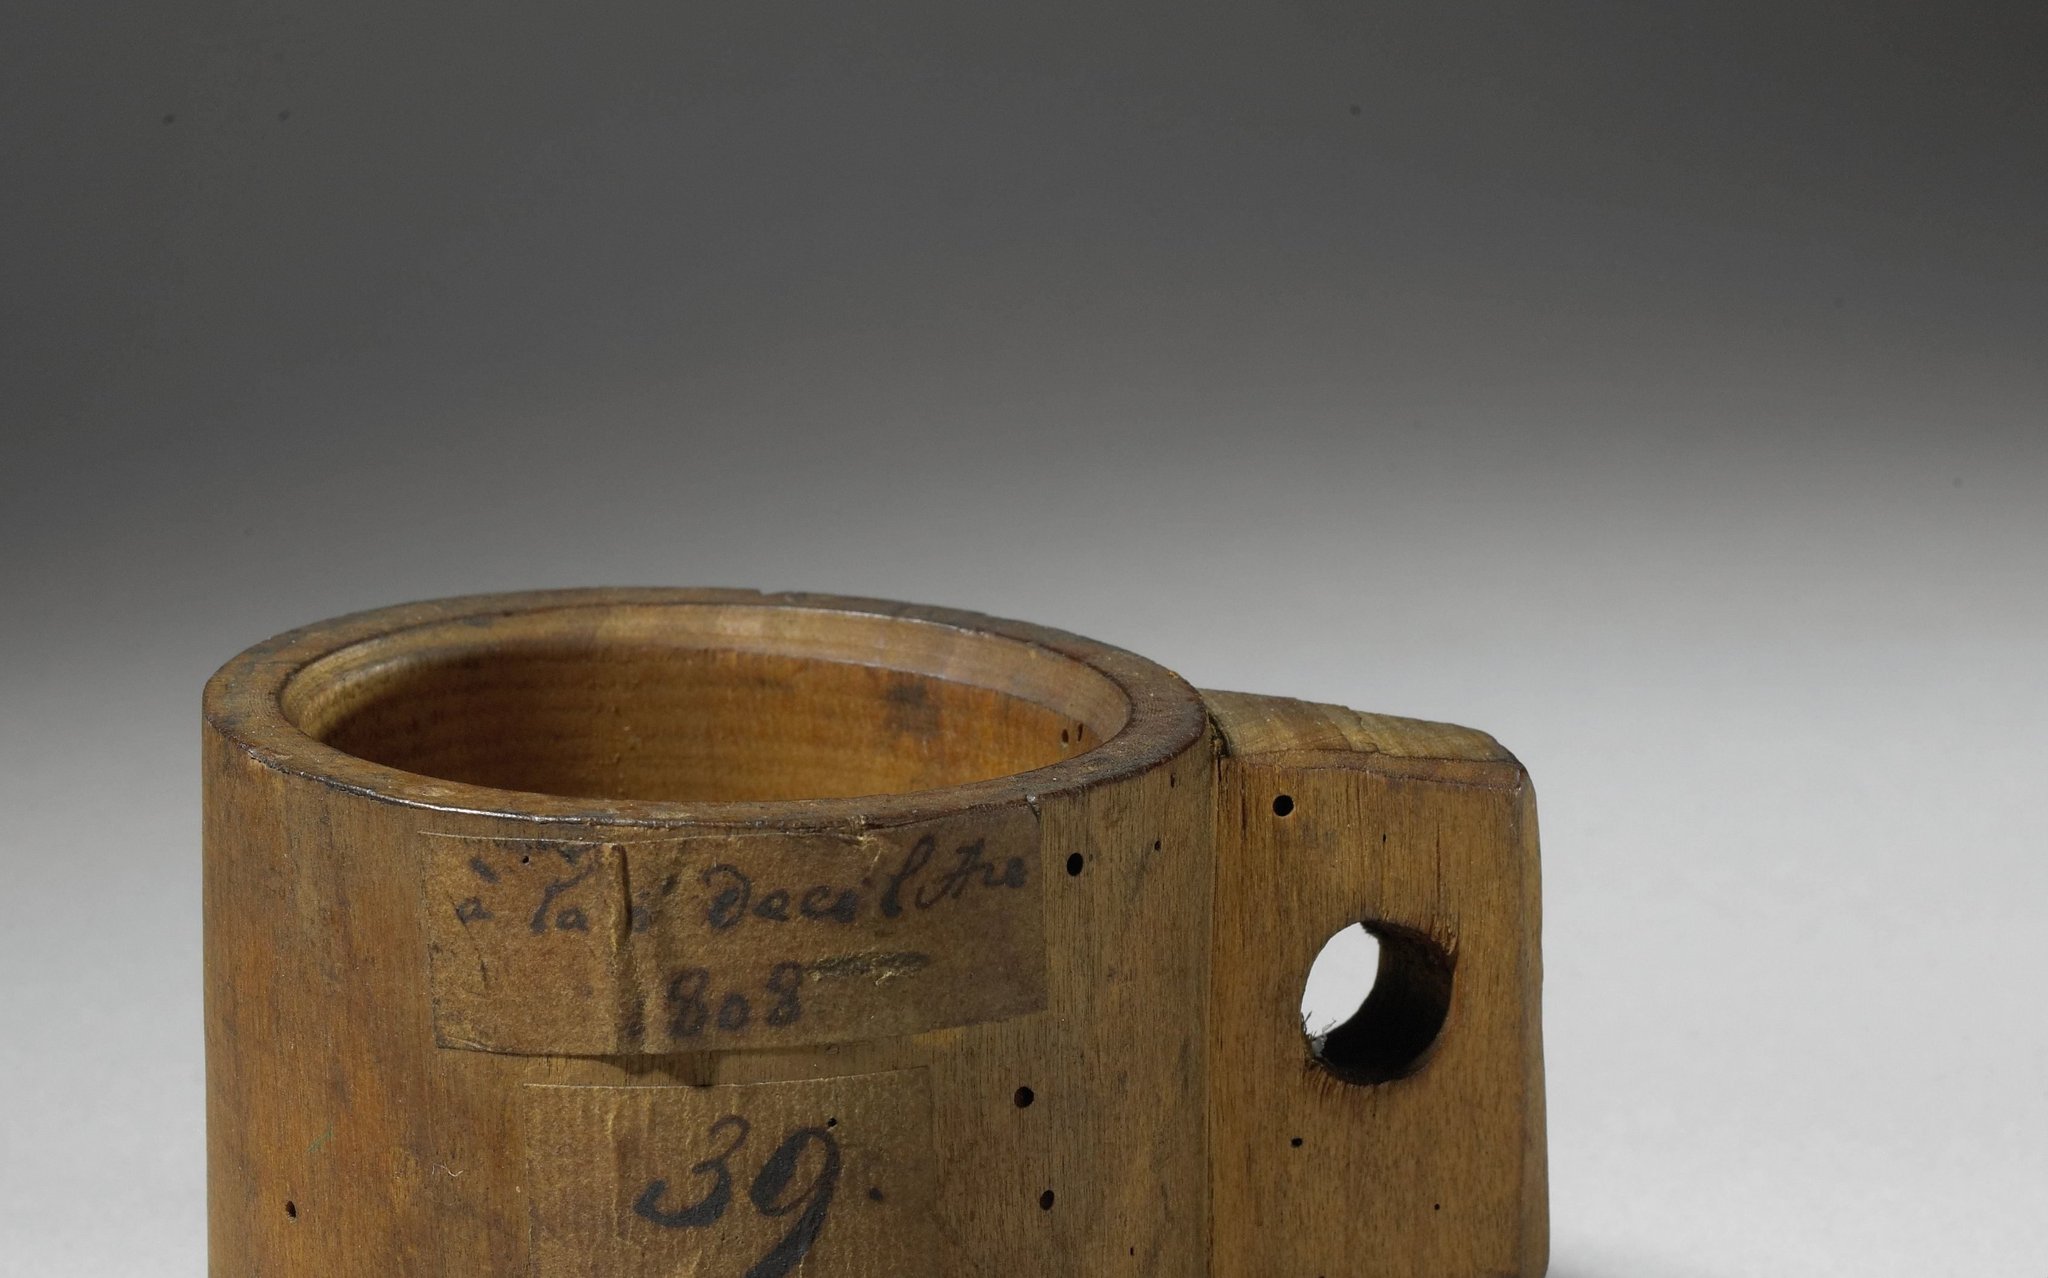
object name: melkmaat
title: Melkmaat van 1 deciliter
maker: Anonymous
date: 1808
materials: wood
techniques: turning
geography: netherlands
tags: netherlands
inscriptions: title: ‘à lait Decilitre / 1808 / nr 39’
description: Inhoudsmaat met oor van 1 deciliter, v.z.v. etiket.